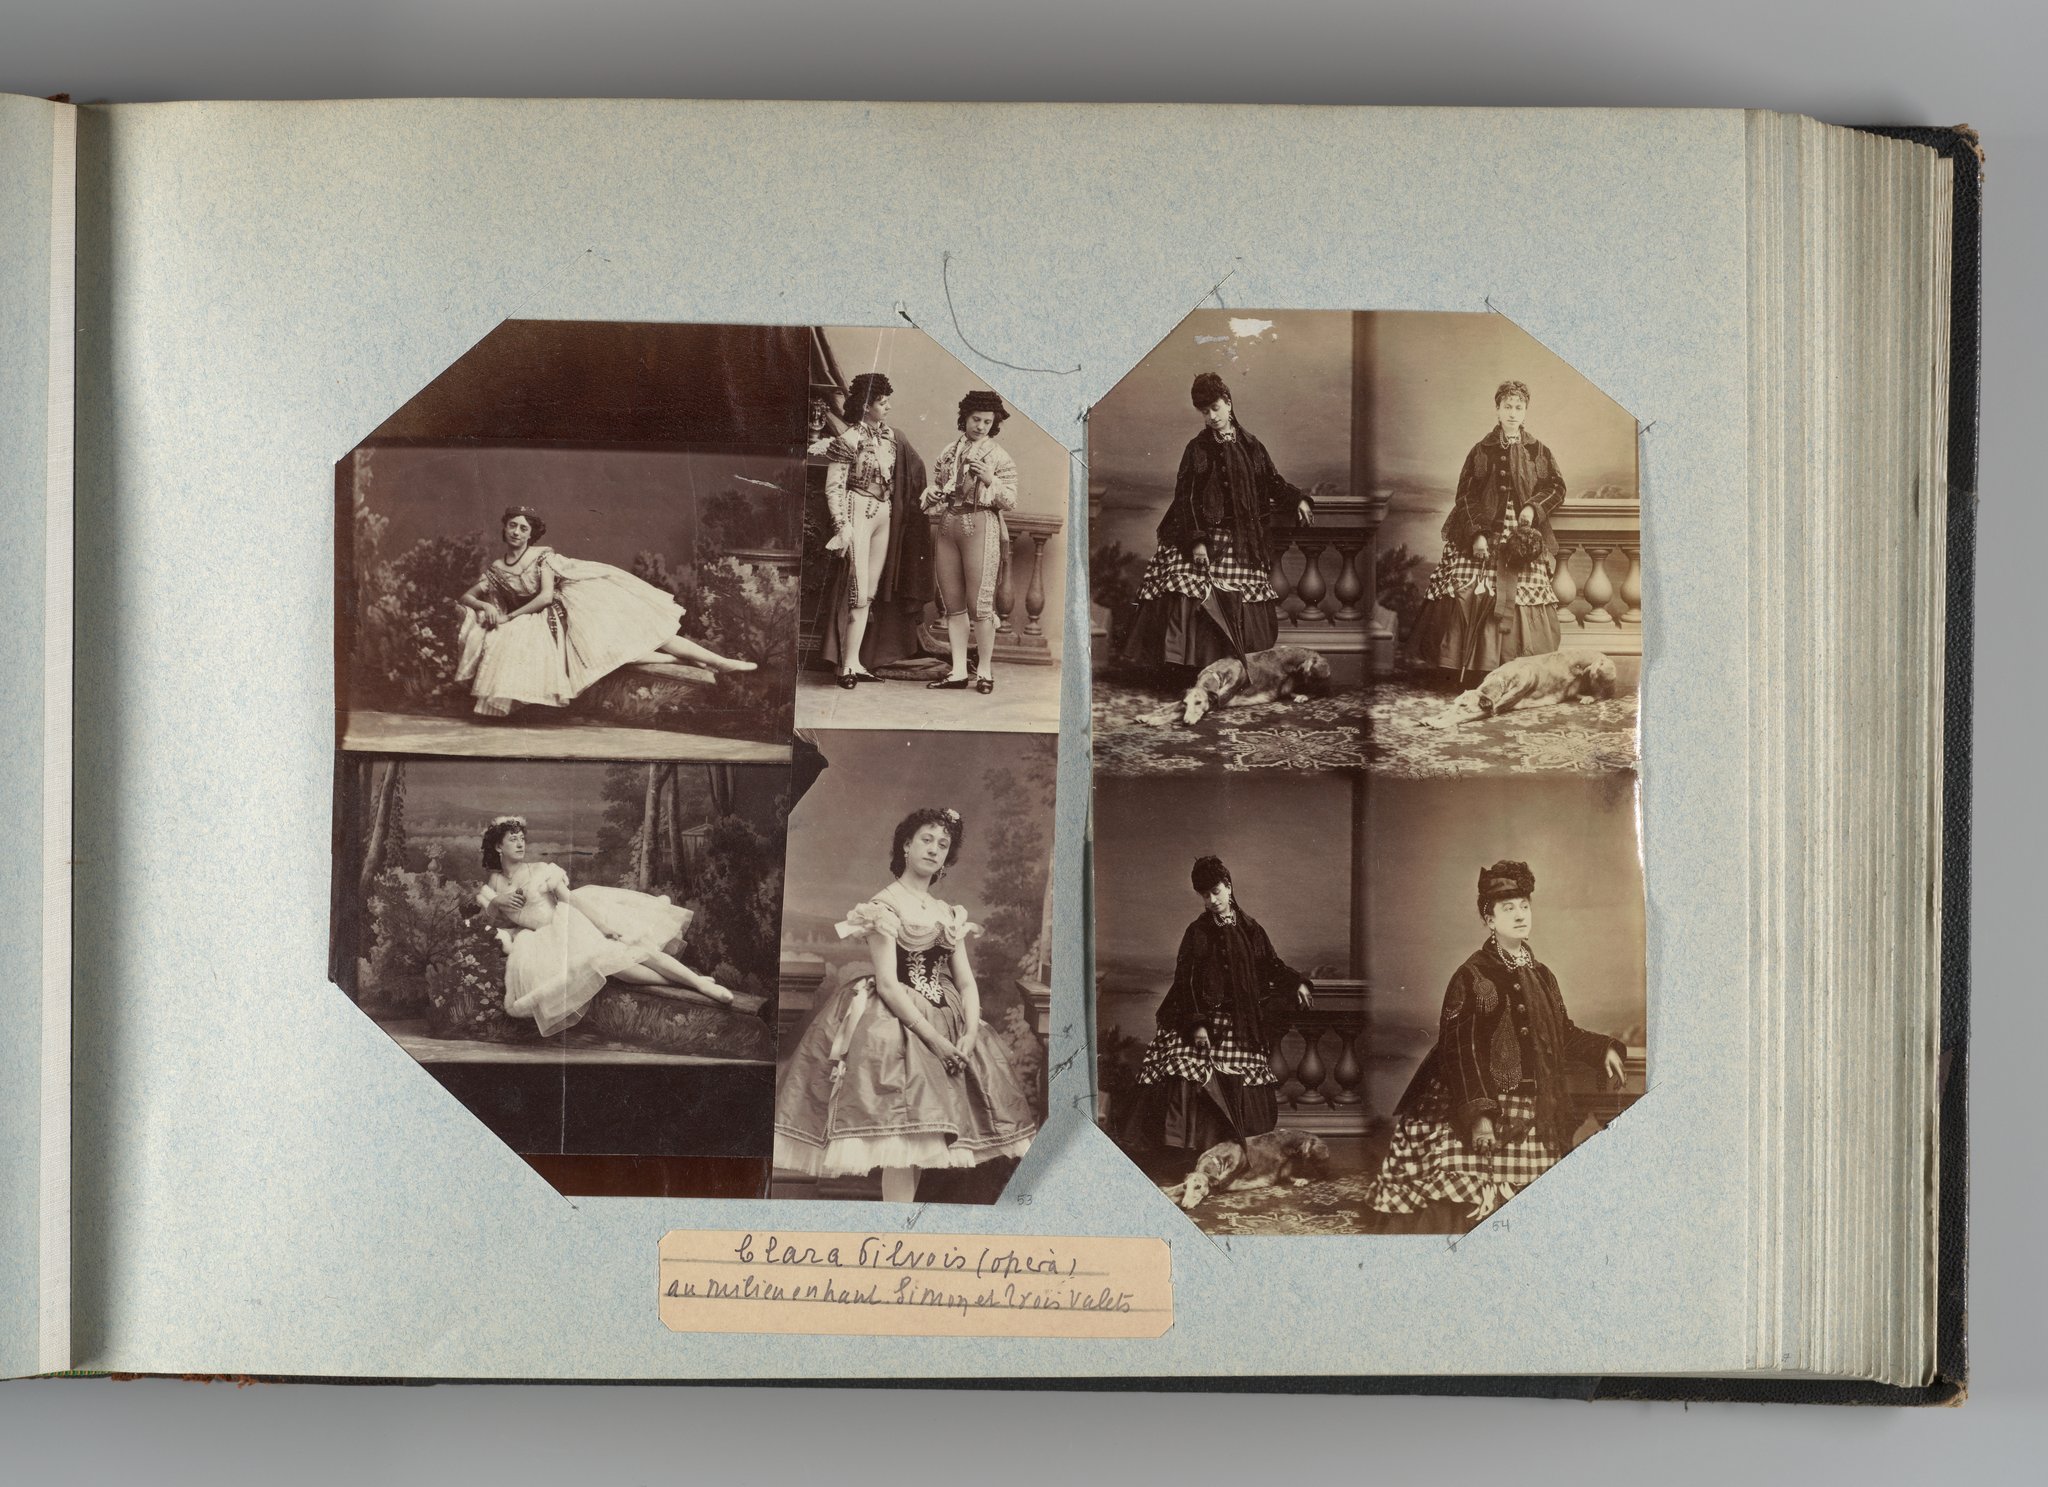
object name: photograph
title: Clara Pilvois; Simon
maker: andré-adolphe-eugène disdéri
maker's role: artist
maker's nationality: french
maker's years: 1819-1889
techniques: albumen silver print, glass negative